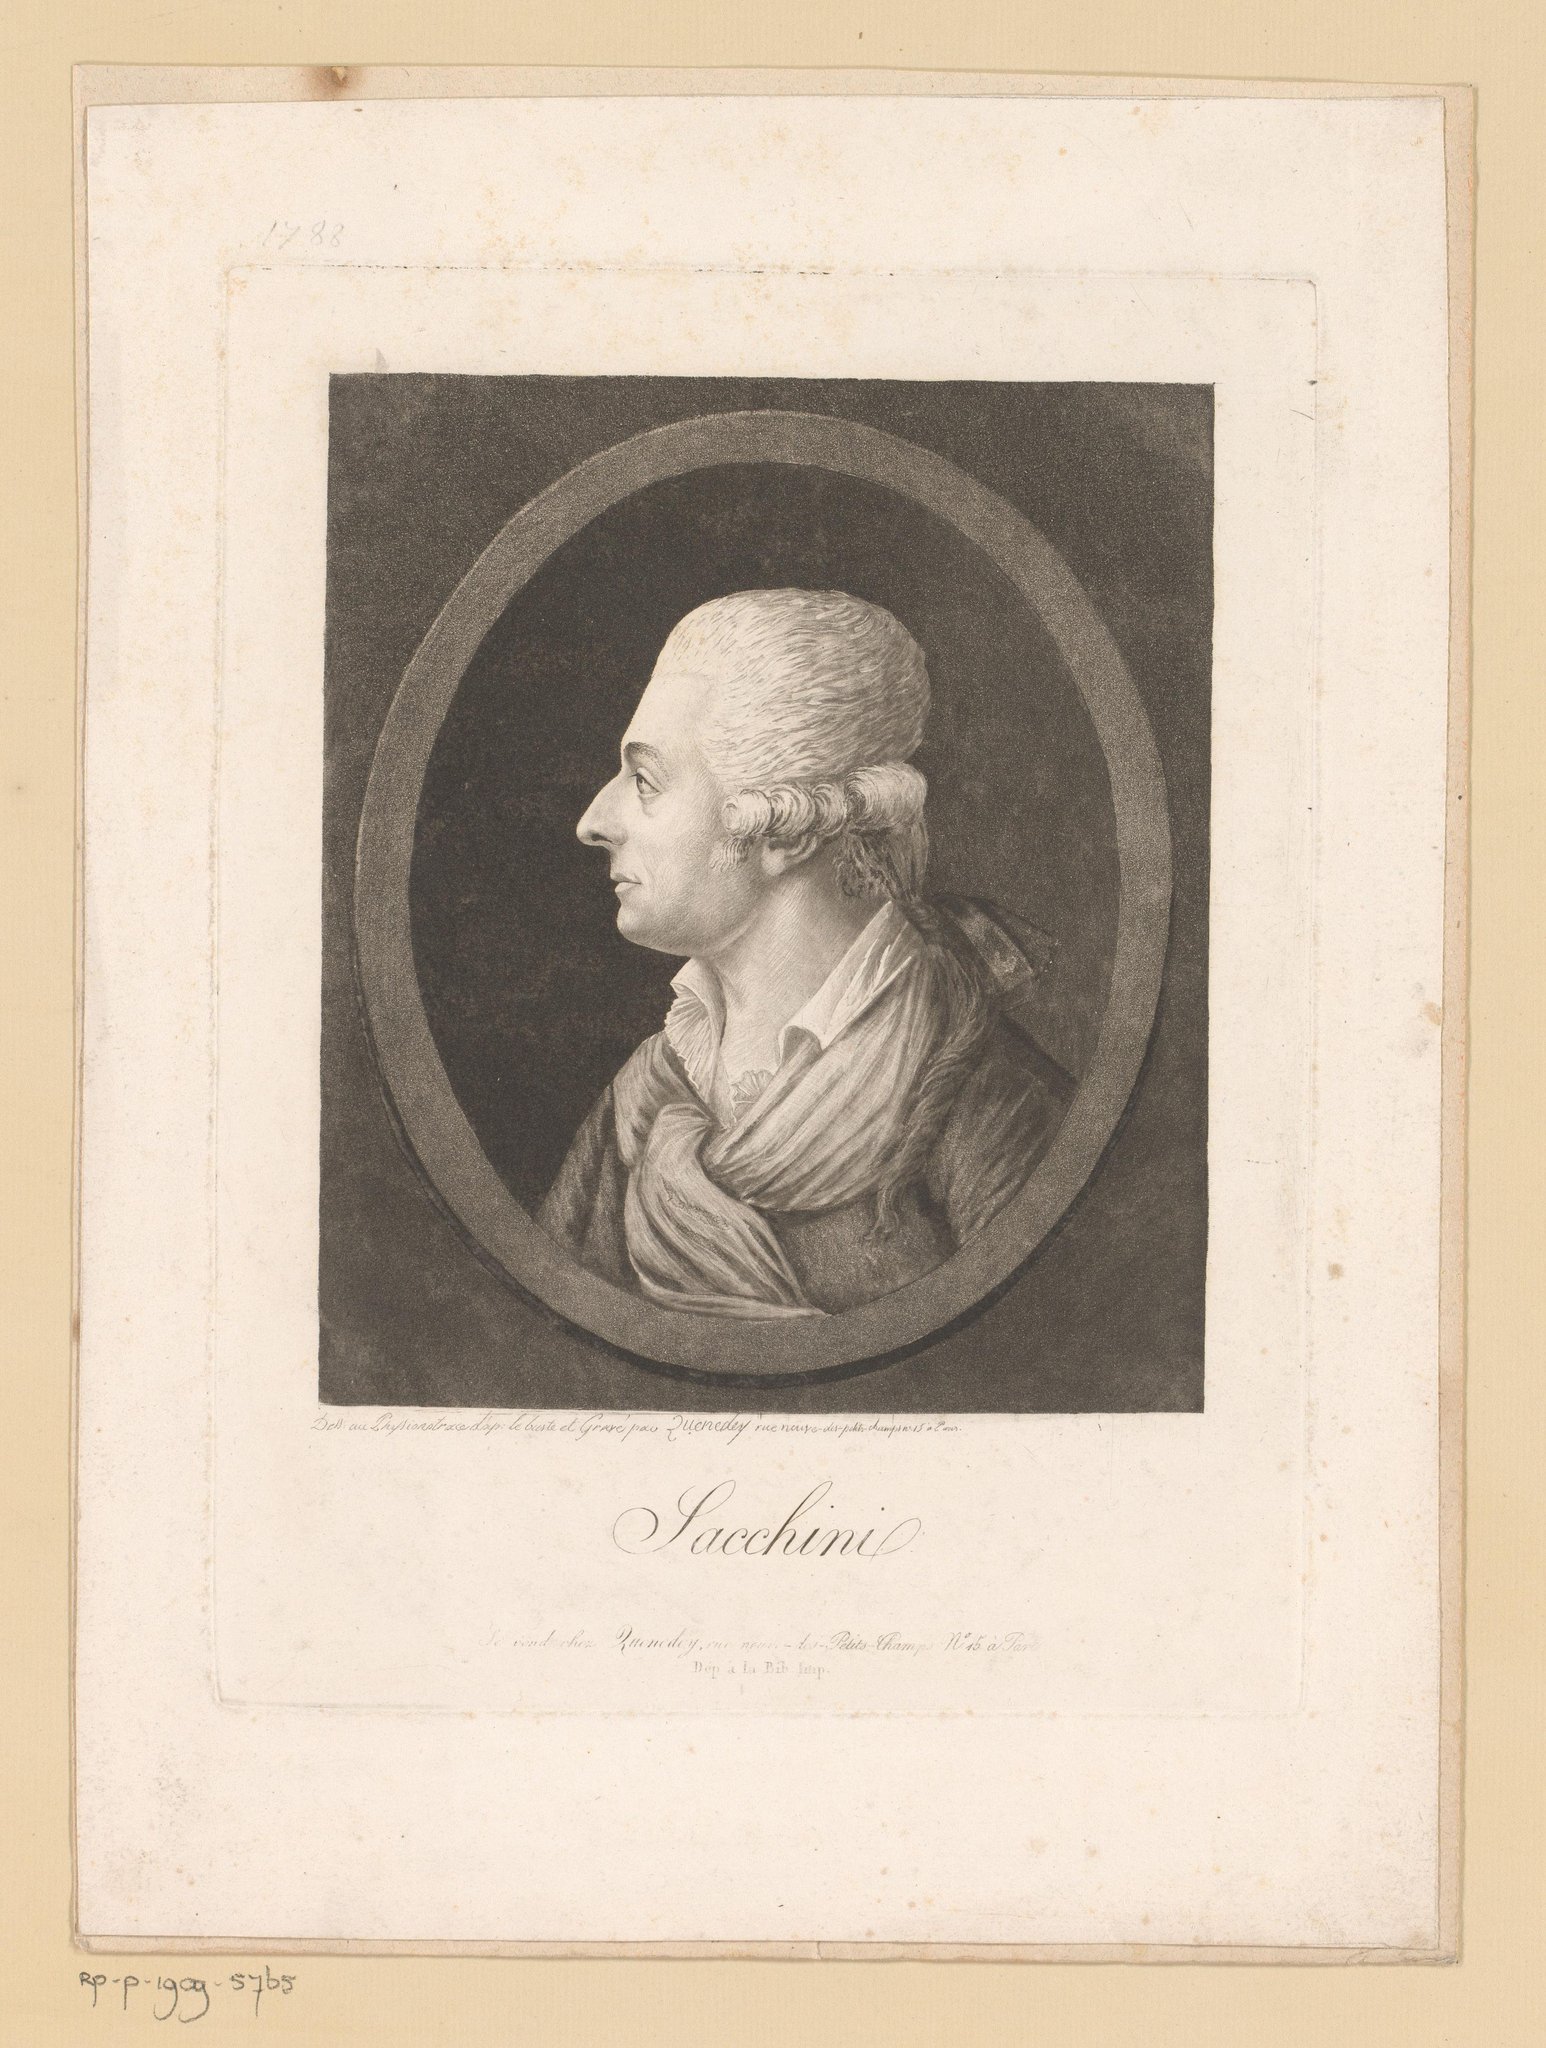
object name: physionotrace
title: Sacchini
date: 1785-1786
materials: paper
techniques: aquatint, etching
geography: paris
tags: paris, silhouette-apparatus, 'physionotrace', historical persons, portrait of composer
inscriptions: collector's mark: Lugt 2228